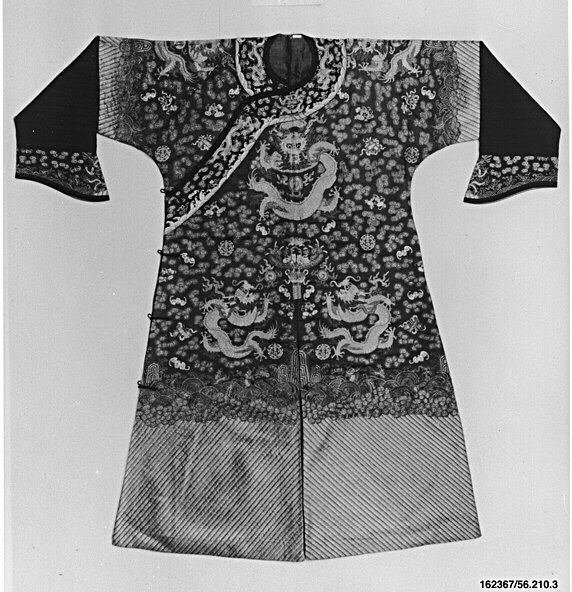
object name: robe, imperial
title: Imperial Robe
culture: chinese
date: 1867-1900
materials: silk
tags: dragons